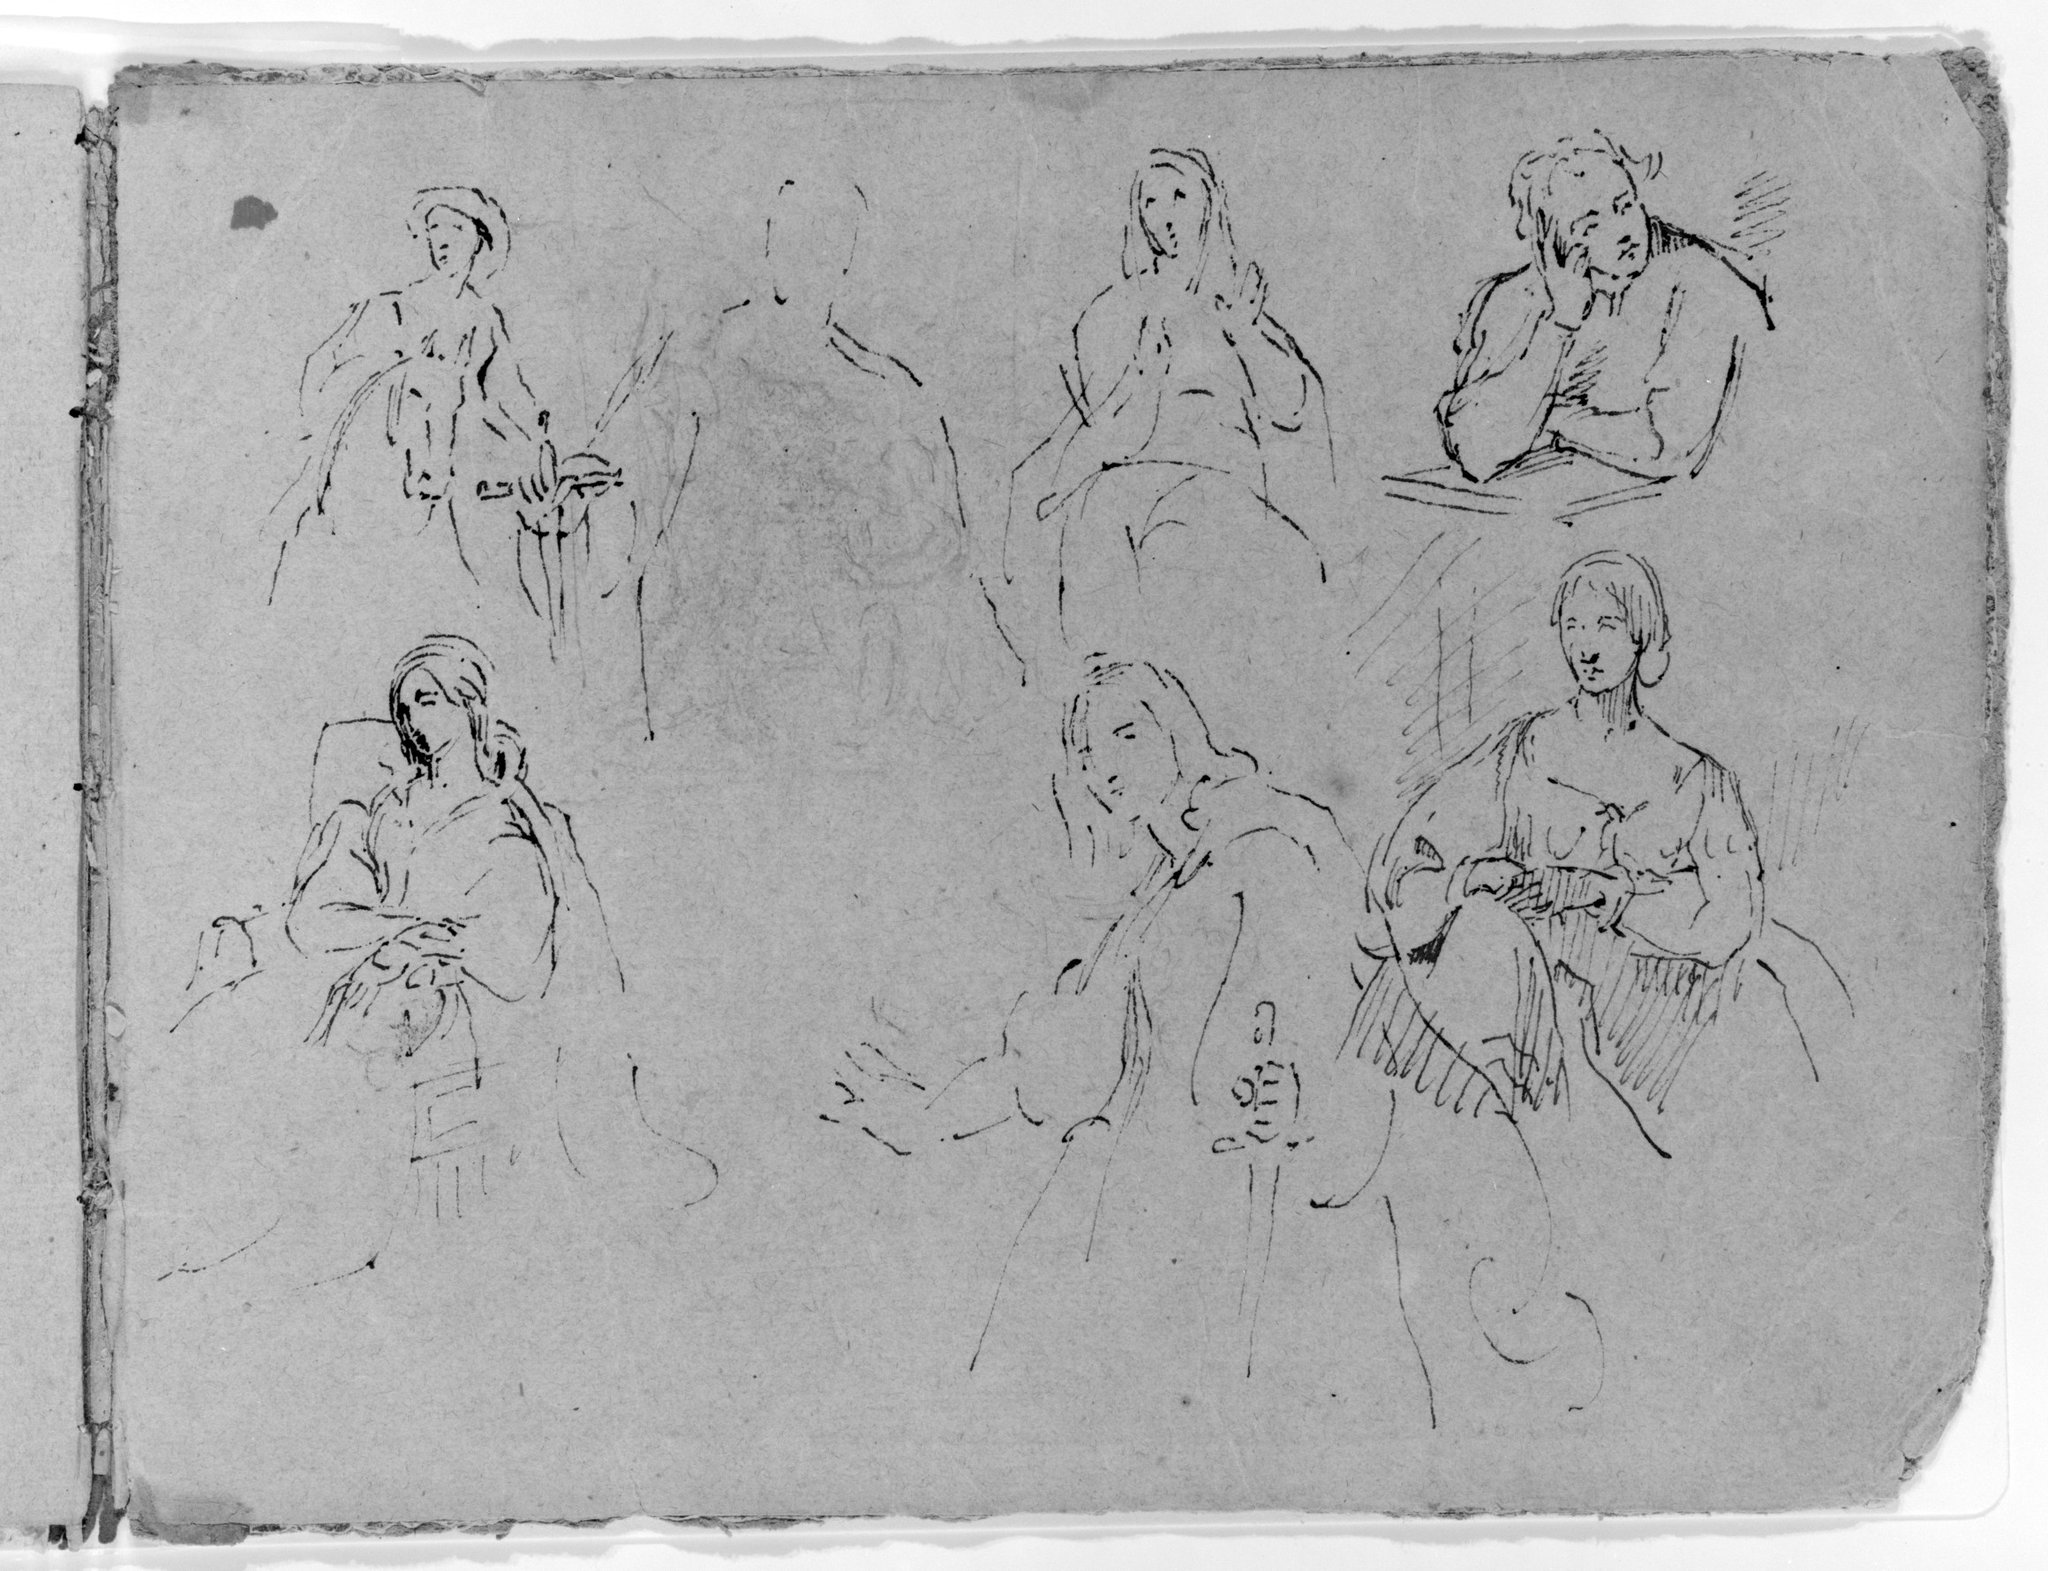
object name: drawing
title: Inside Back Cover (from Sketchbook)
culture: american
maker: thomas sully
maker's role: artist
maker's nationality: american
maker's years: 1783-1872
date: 1810-1820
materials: ink, paper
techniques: wash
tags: women